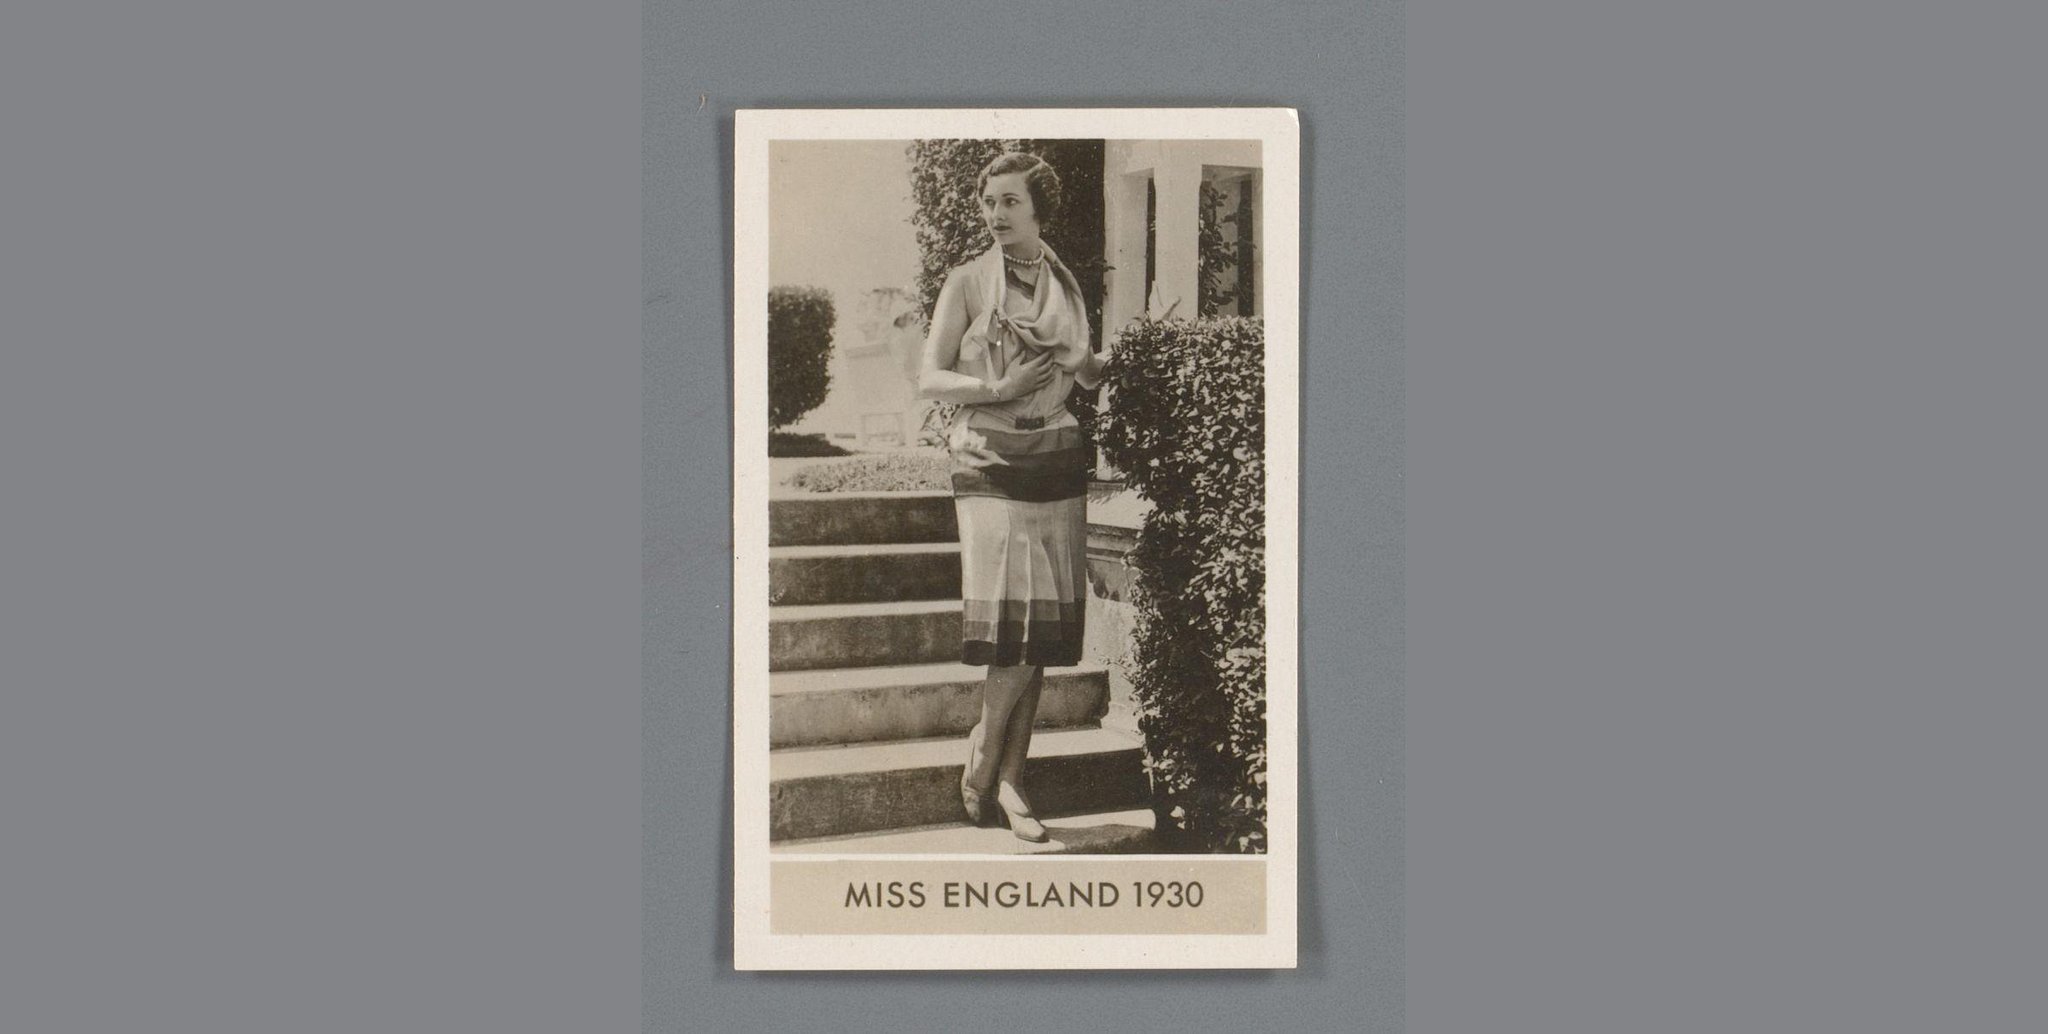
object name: photograph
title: Miss England 1930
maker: Anonymous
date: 1930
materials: paper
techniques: gelatin silver print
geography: dresden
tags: historical persons - bb - woman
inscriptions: inscription: ‘Die schönsten/ Frauen der Welt/ dargestellt durch die Schön-/ heitsköniginnen aller Länder,/ finden Sie in 190 echten/ Bromsilber-Fotos, die nur den/ CLUB-und-LIGA-Packun-/ gen beiliegen. Eind prächtiges/ Sammel-Album erhalten Sie/ für 75 Pfennig vom Händler/ oder bei Einsendung von/ 75 Pfennig in Briefmarken/ von der Bilderstelle Lohse,/ Dresden A24, Nossener Str. 1./ Ges. gesch. Nachdruck verboten!’